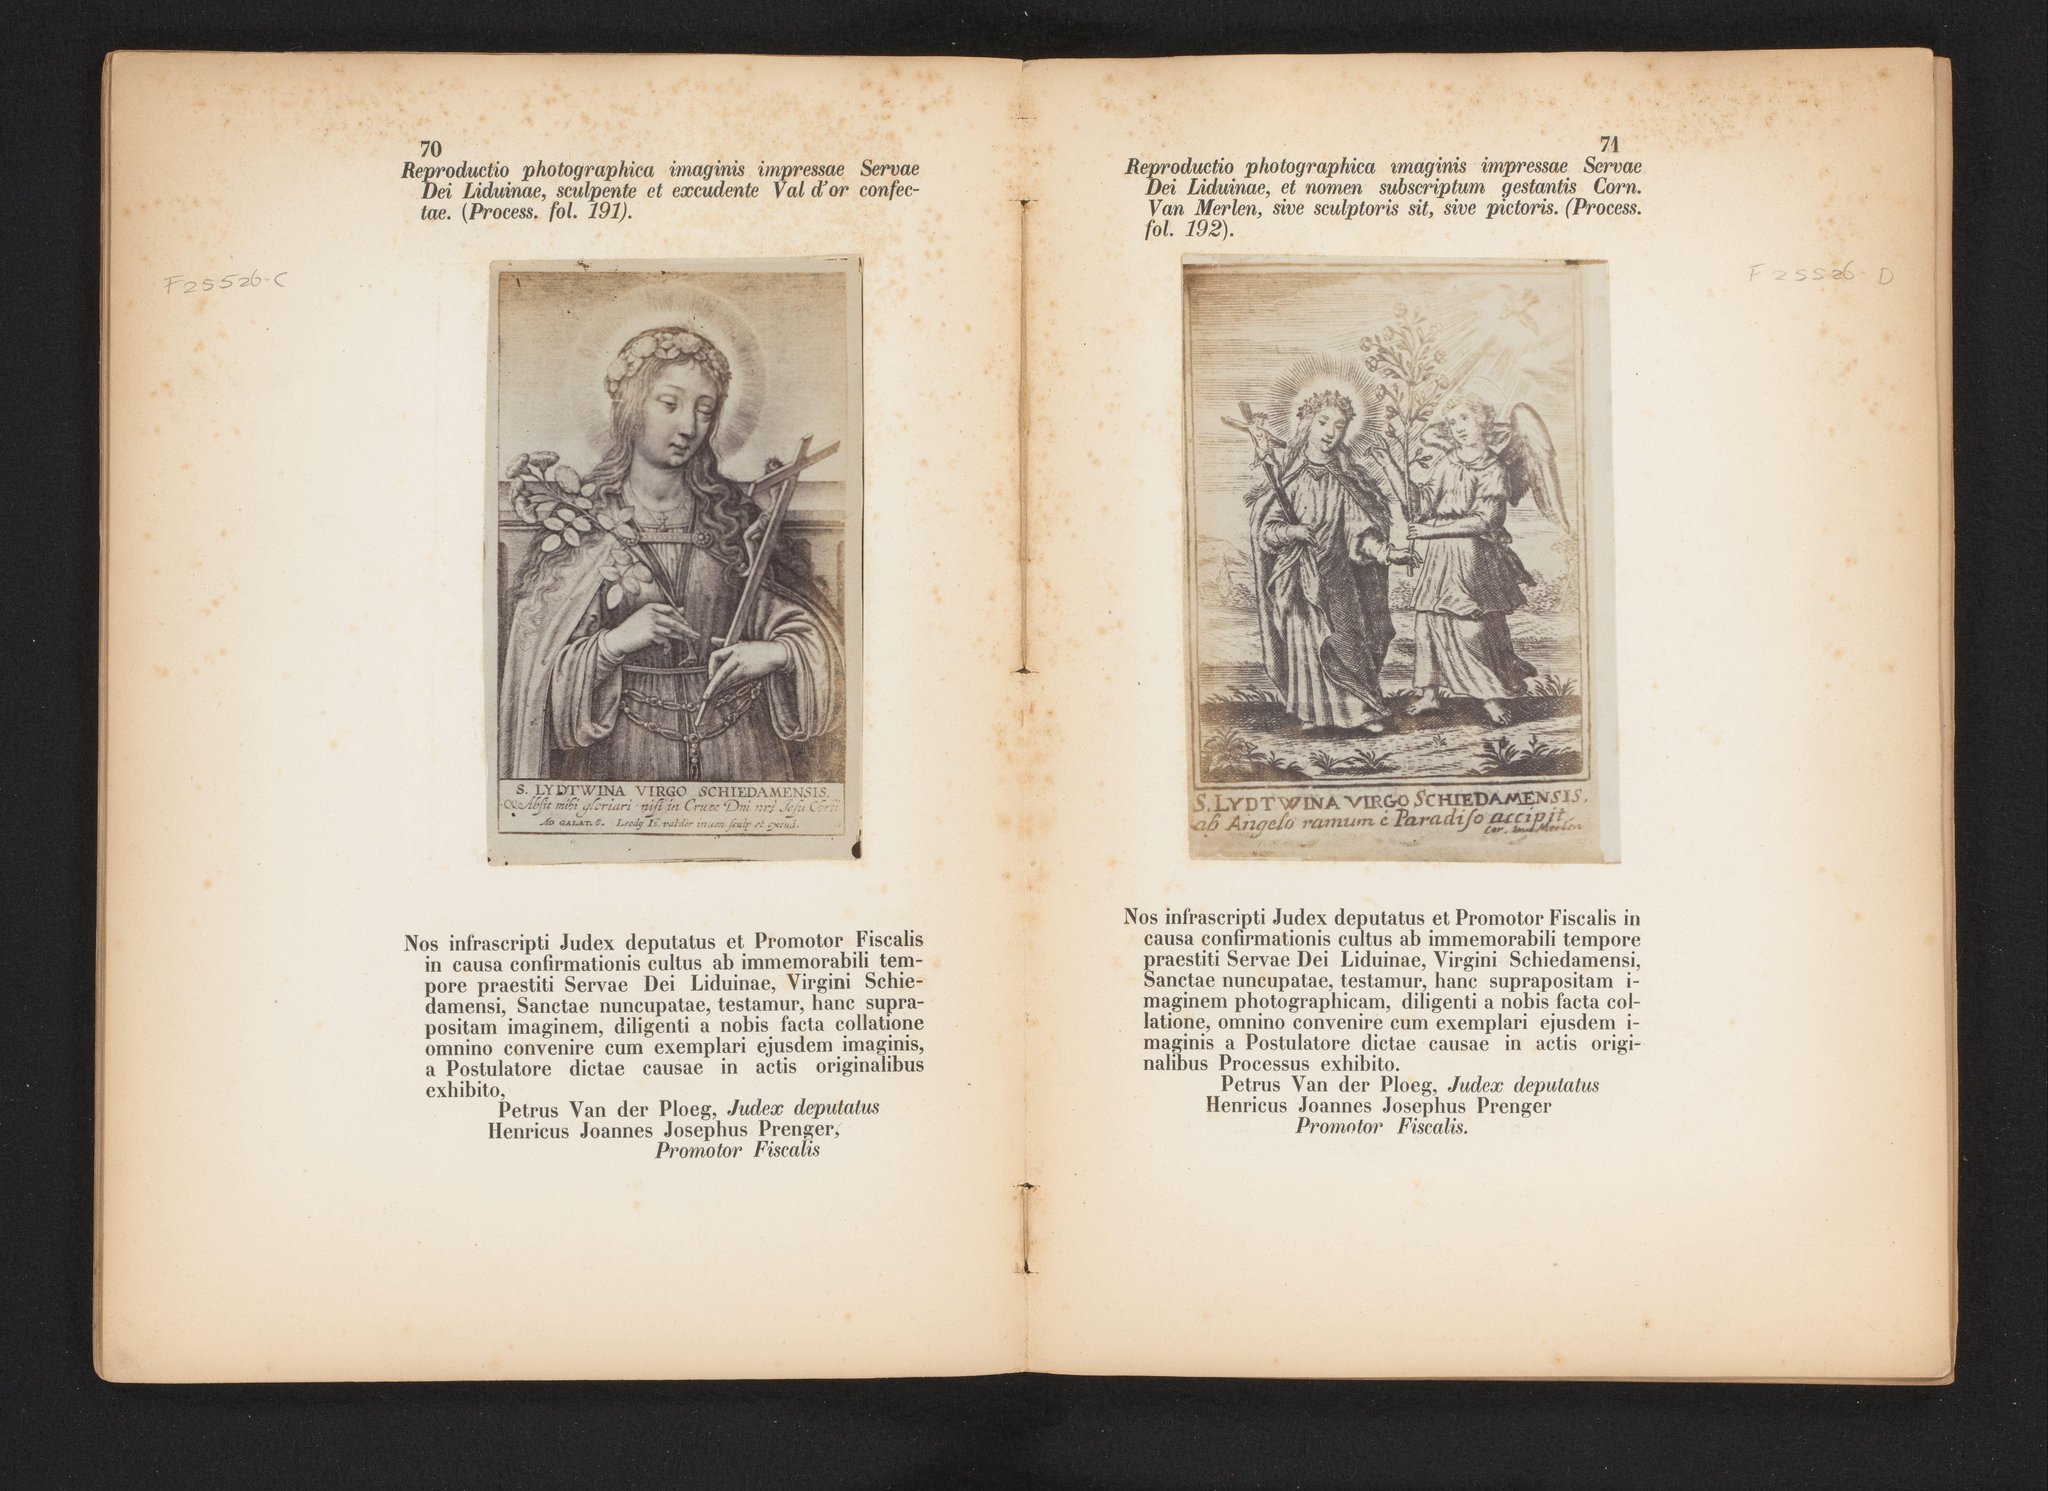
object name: page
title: Fotoreproductie van een gravure van Liduina van Schiedam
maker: Anonymous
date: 1856-1877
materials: paper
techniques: albumen print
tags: the virgin lidwyna (lydwine) of schiedam; possible attributes: crucifix, branch of roses in hand, roses in hair